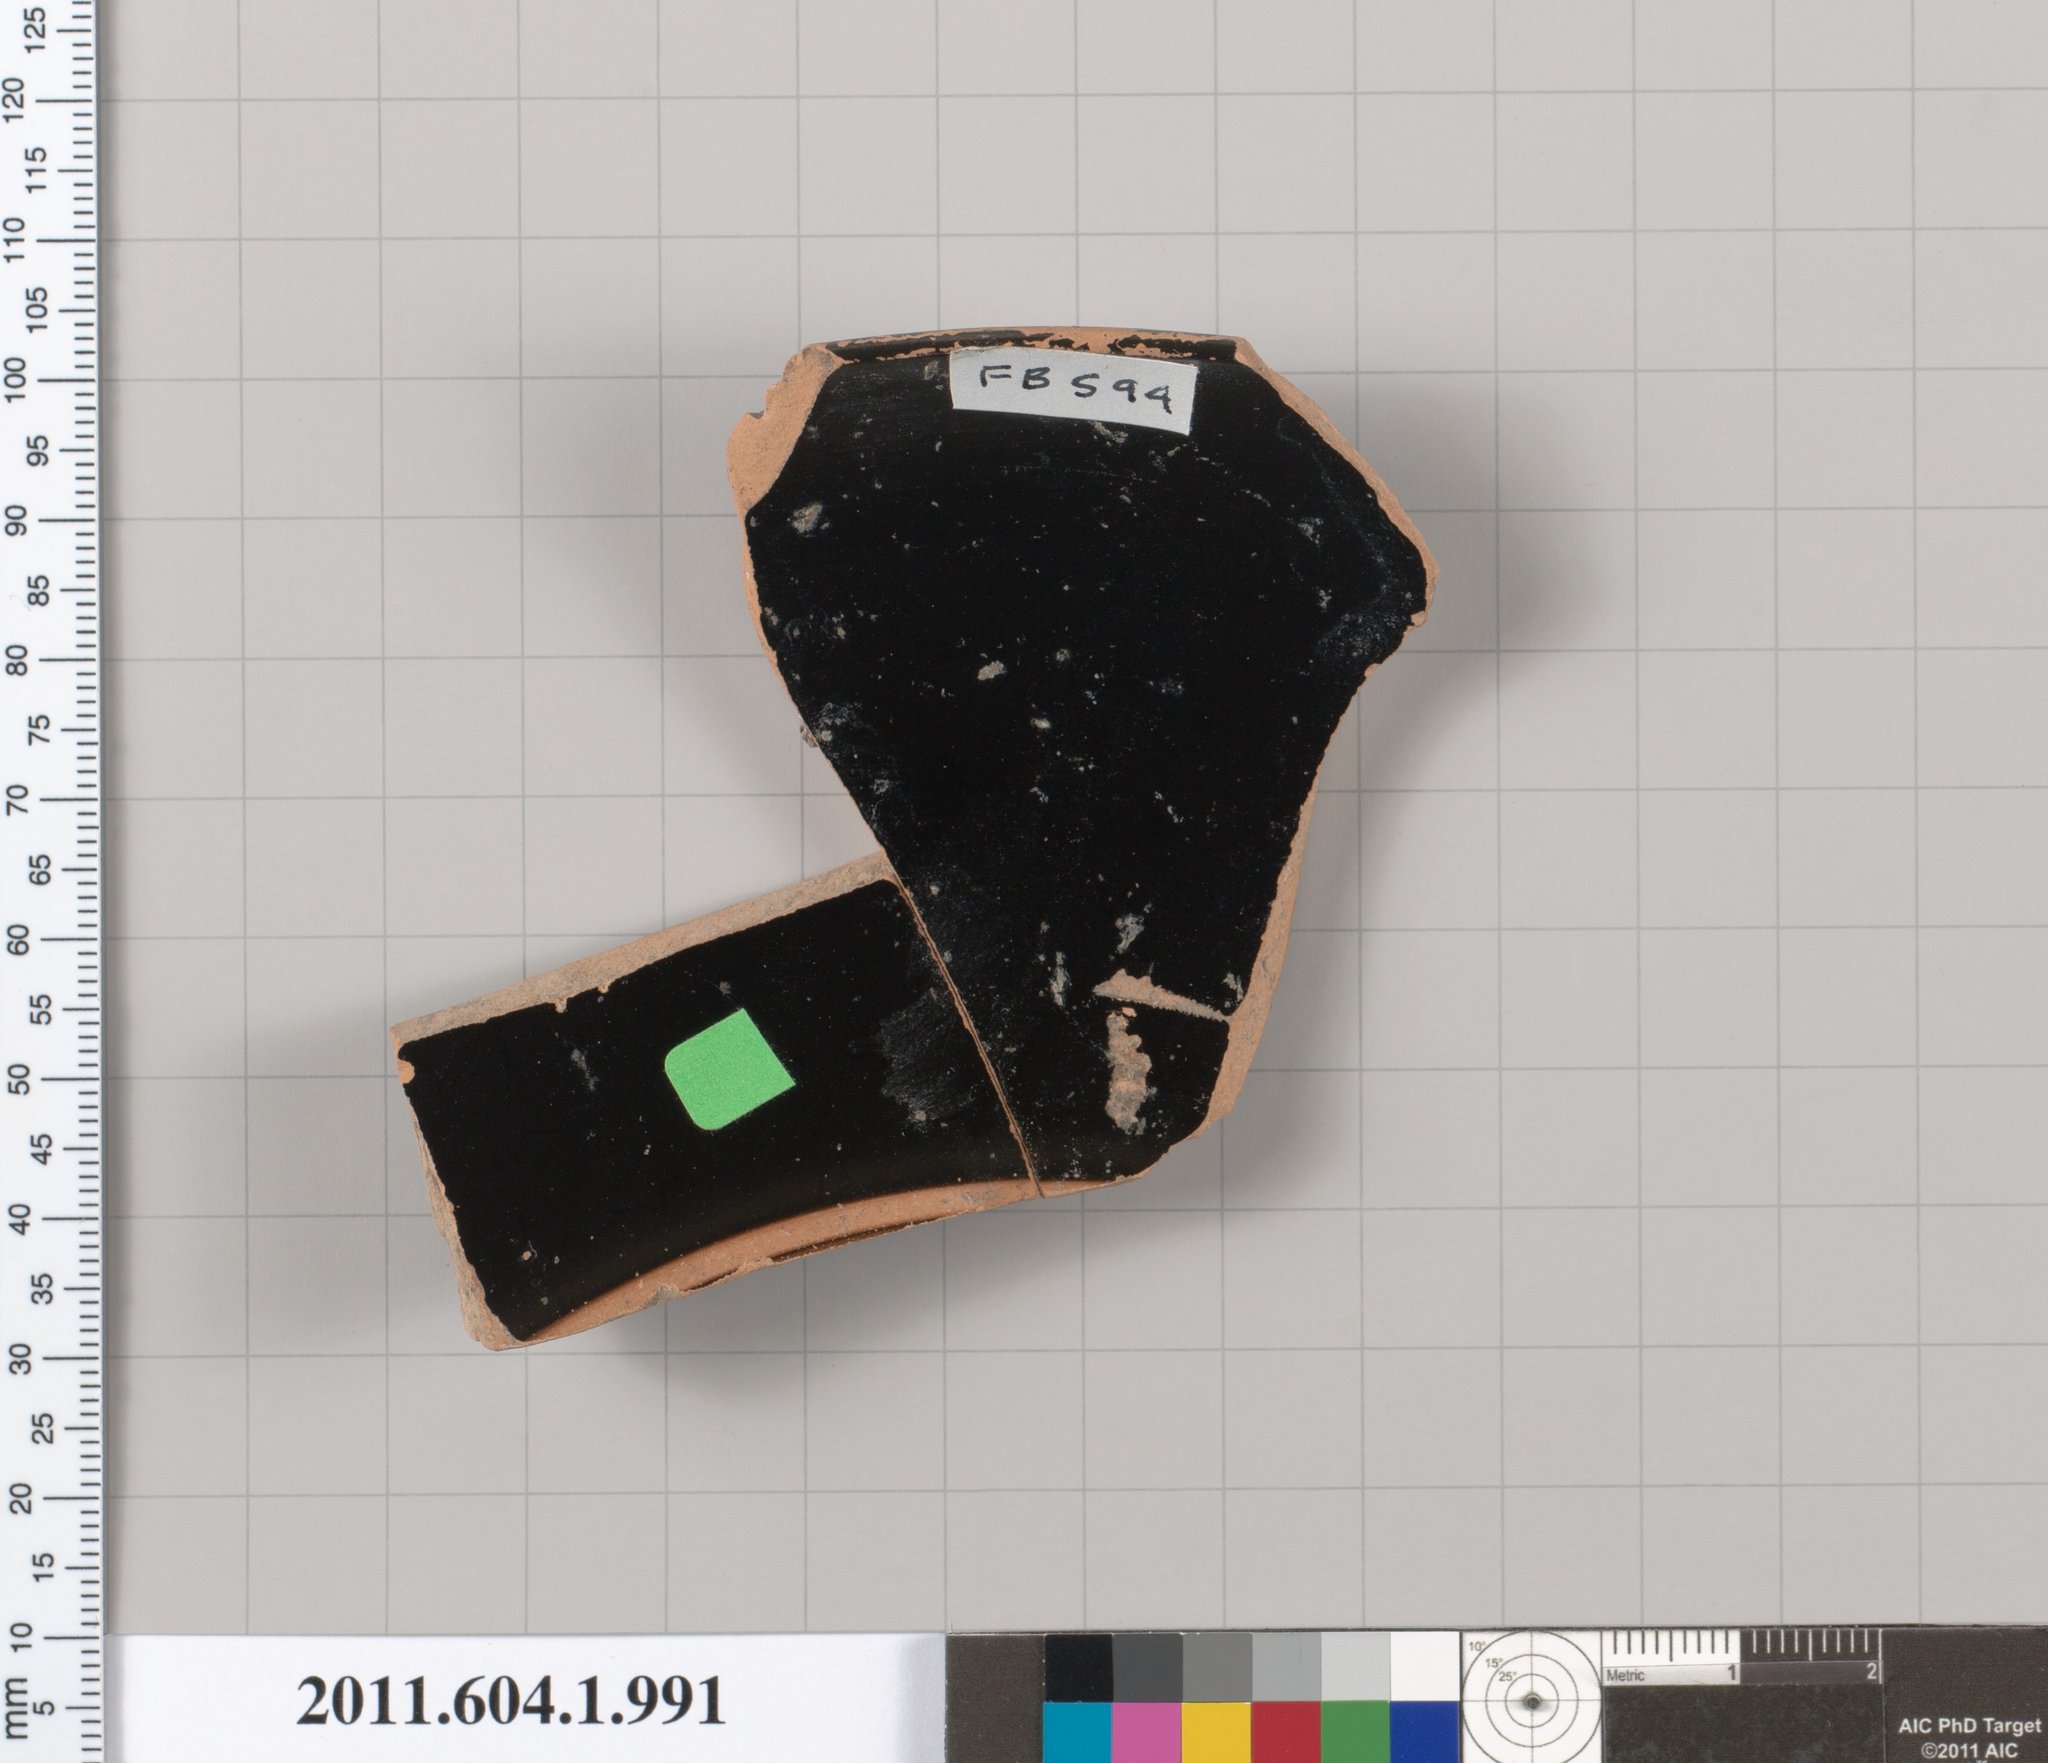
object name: kylix fragment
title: Terracotta fragment of a kylix (drinking cup)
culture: greek, attic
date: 475-451 BCE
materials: terracotta